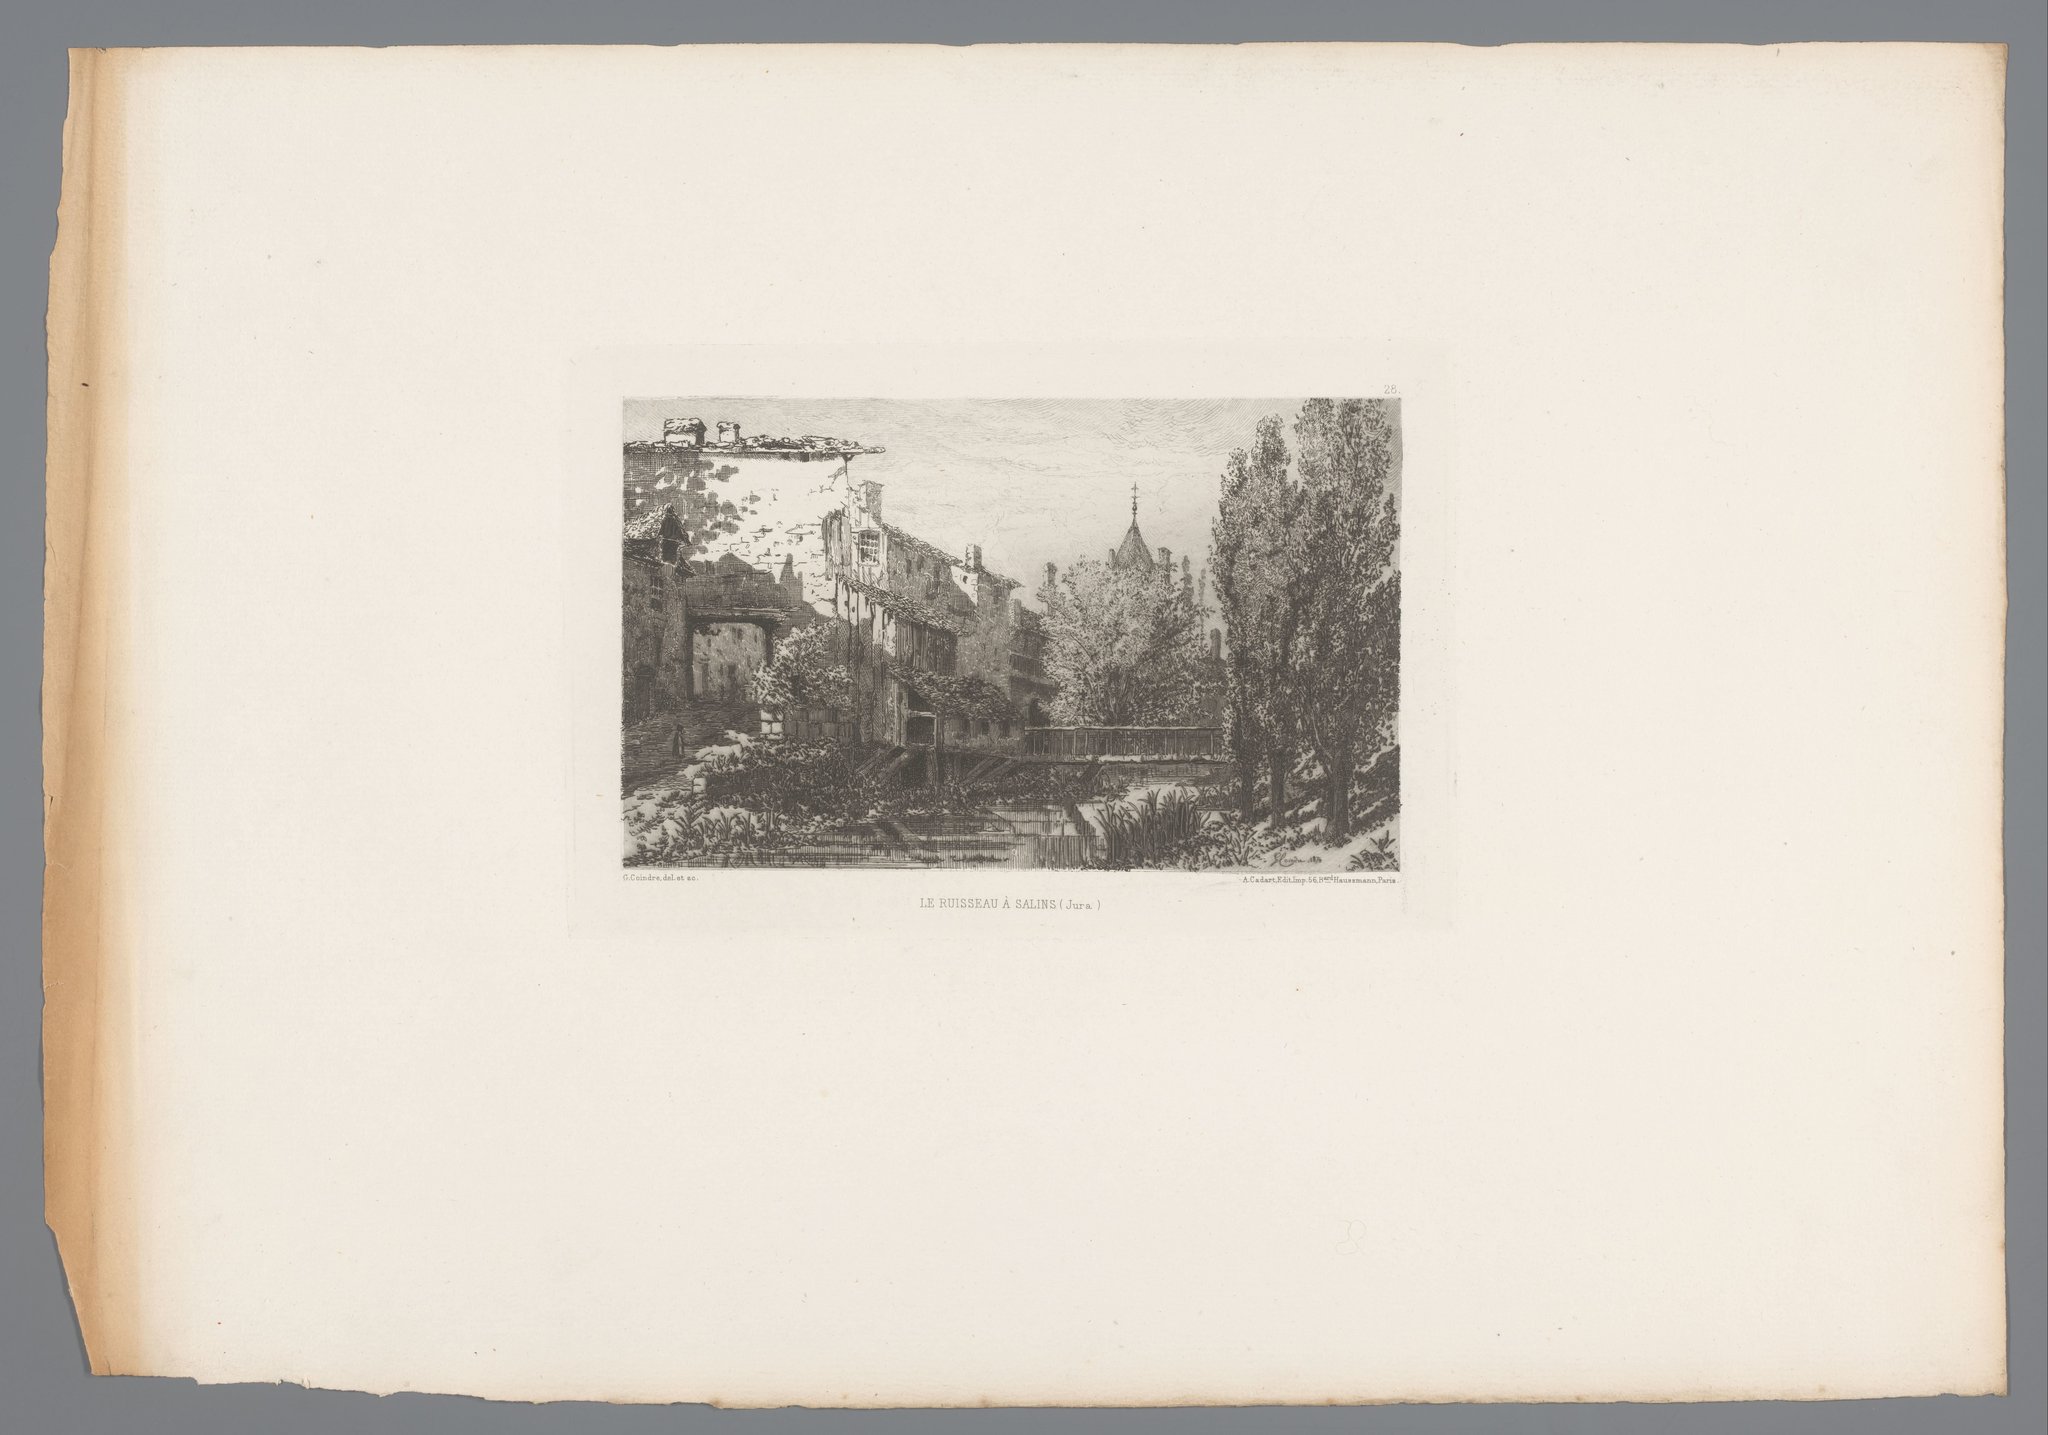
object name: print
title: Franse etsen uit 1875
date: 1875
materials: paper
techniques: drypoint, etching, intaglio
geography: paris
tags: water course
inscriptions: collector's mark: Lugt 2228, collector's mark: Lugt 2760, collector's mark: ‘AFE v S’